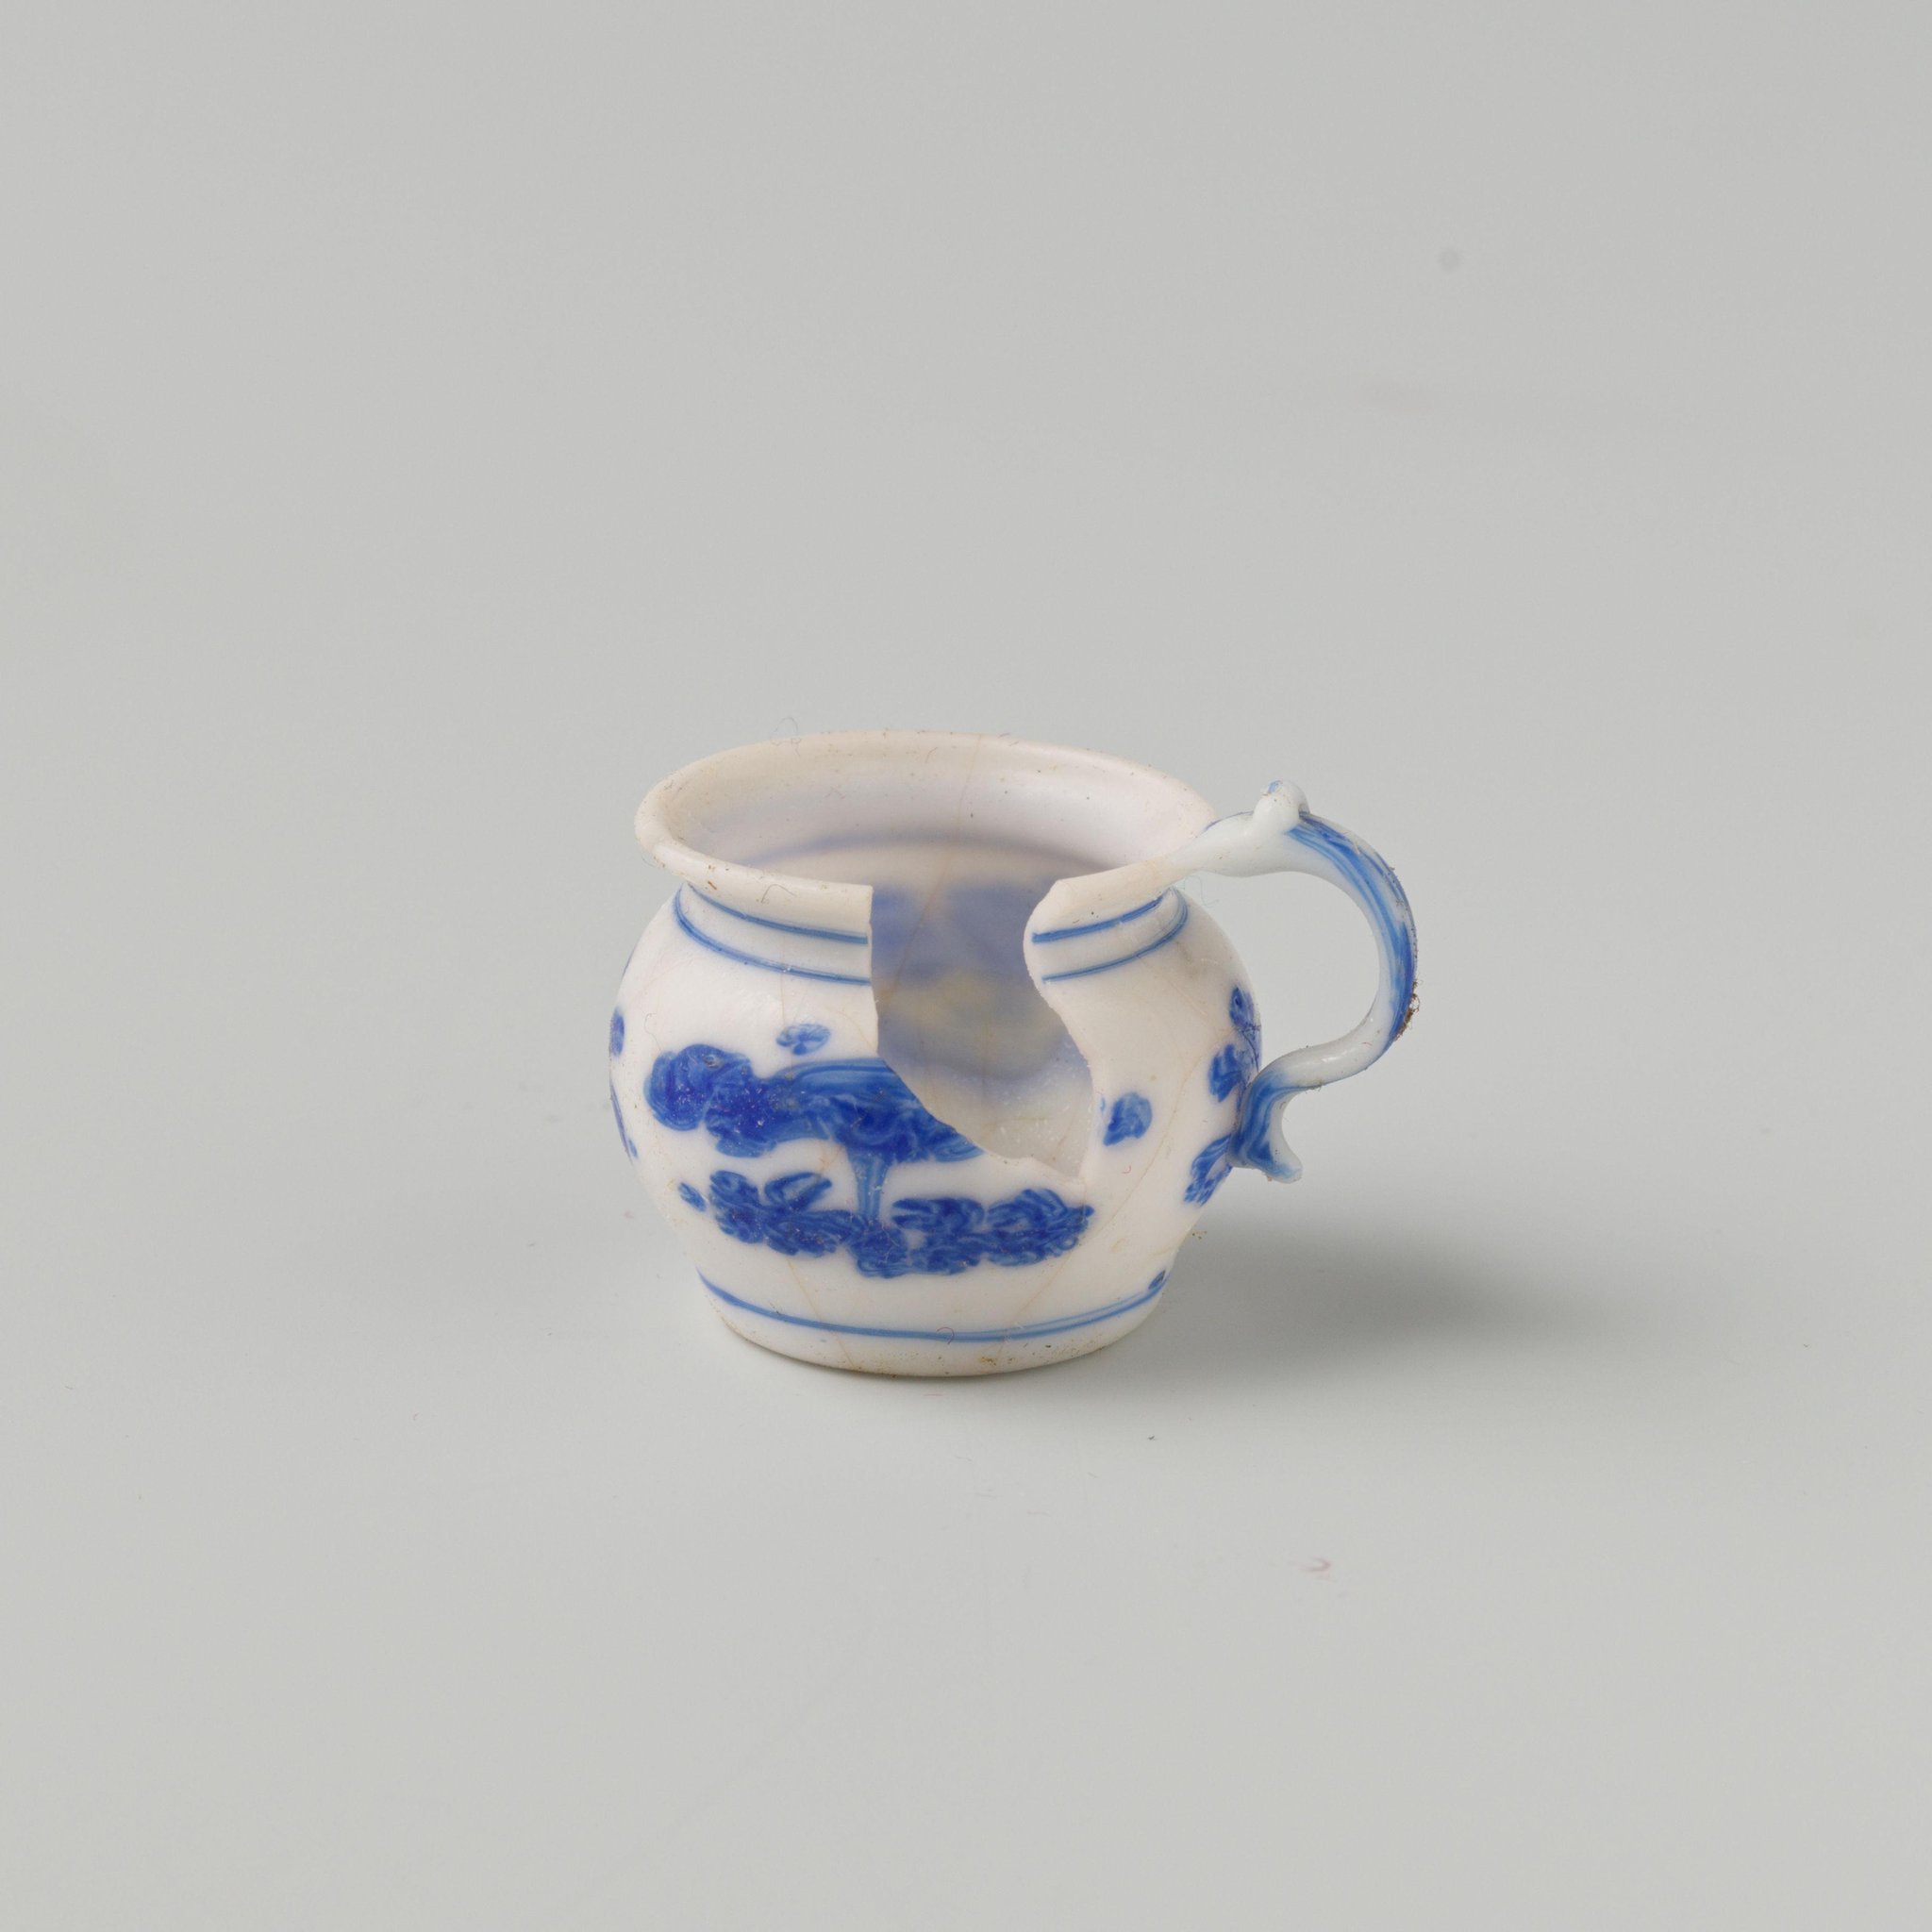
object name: chamber pot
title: Kamerpot of po van melkglas met blauwe emailverf beschildering, imitatie Chinees porselein; decoratie van bloemmotieven, s-vormig oor met duimstukje.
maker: Anonymous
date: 1675-1710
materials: glass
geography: amsterdam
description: Kamerpot of po van kelkglas met blauwe emailverf beschildering, imitatie chinees blauw porselein; decoratie van bloemmotieven, s-vormig oor met duimstukje.